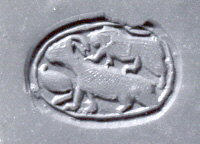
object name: stamp seal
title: Scarab seal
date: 1700-1560 BCE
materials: faience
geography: levant or syria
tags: scarabs